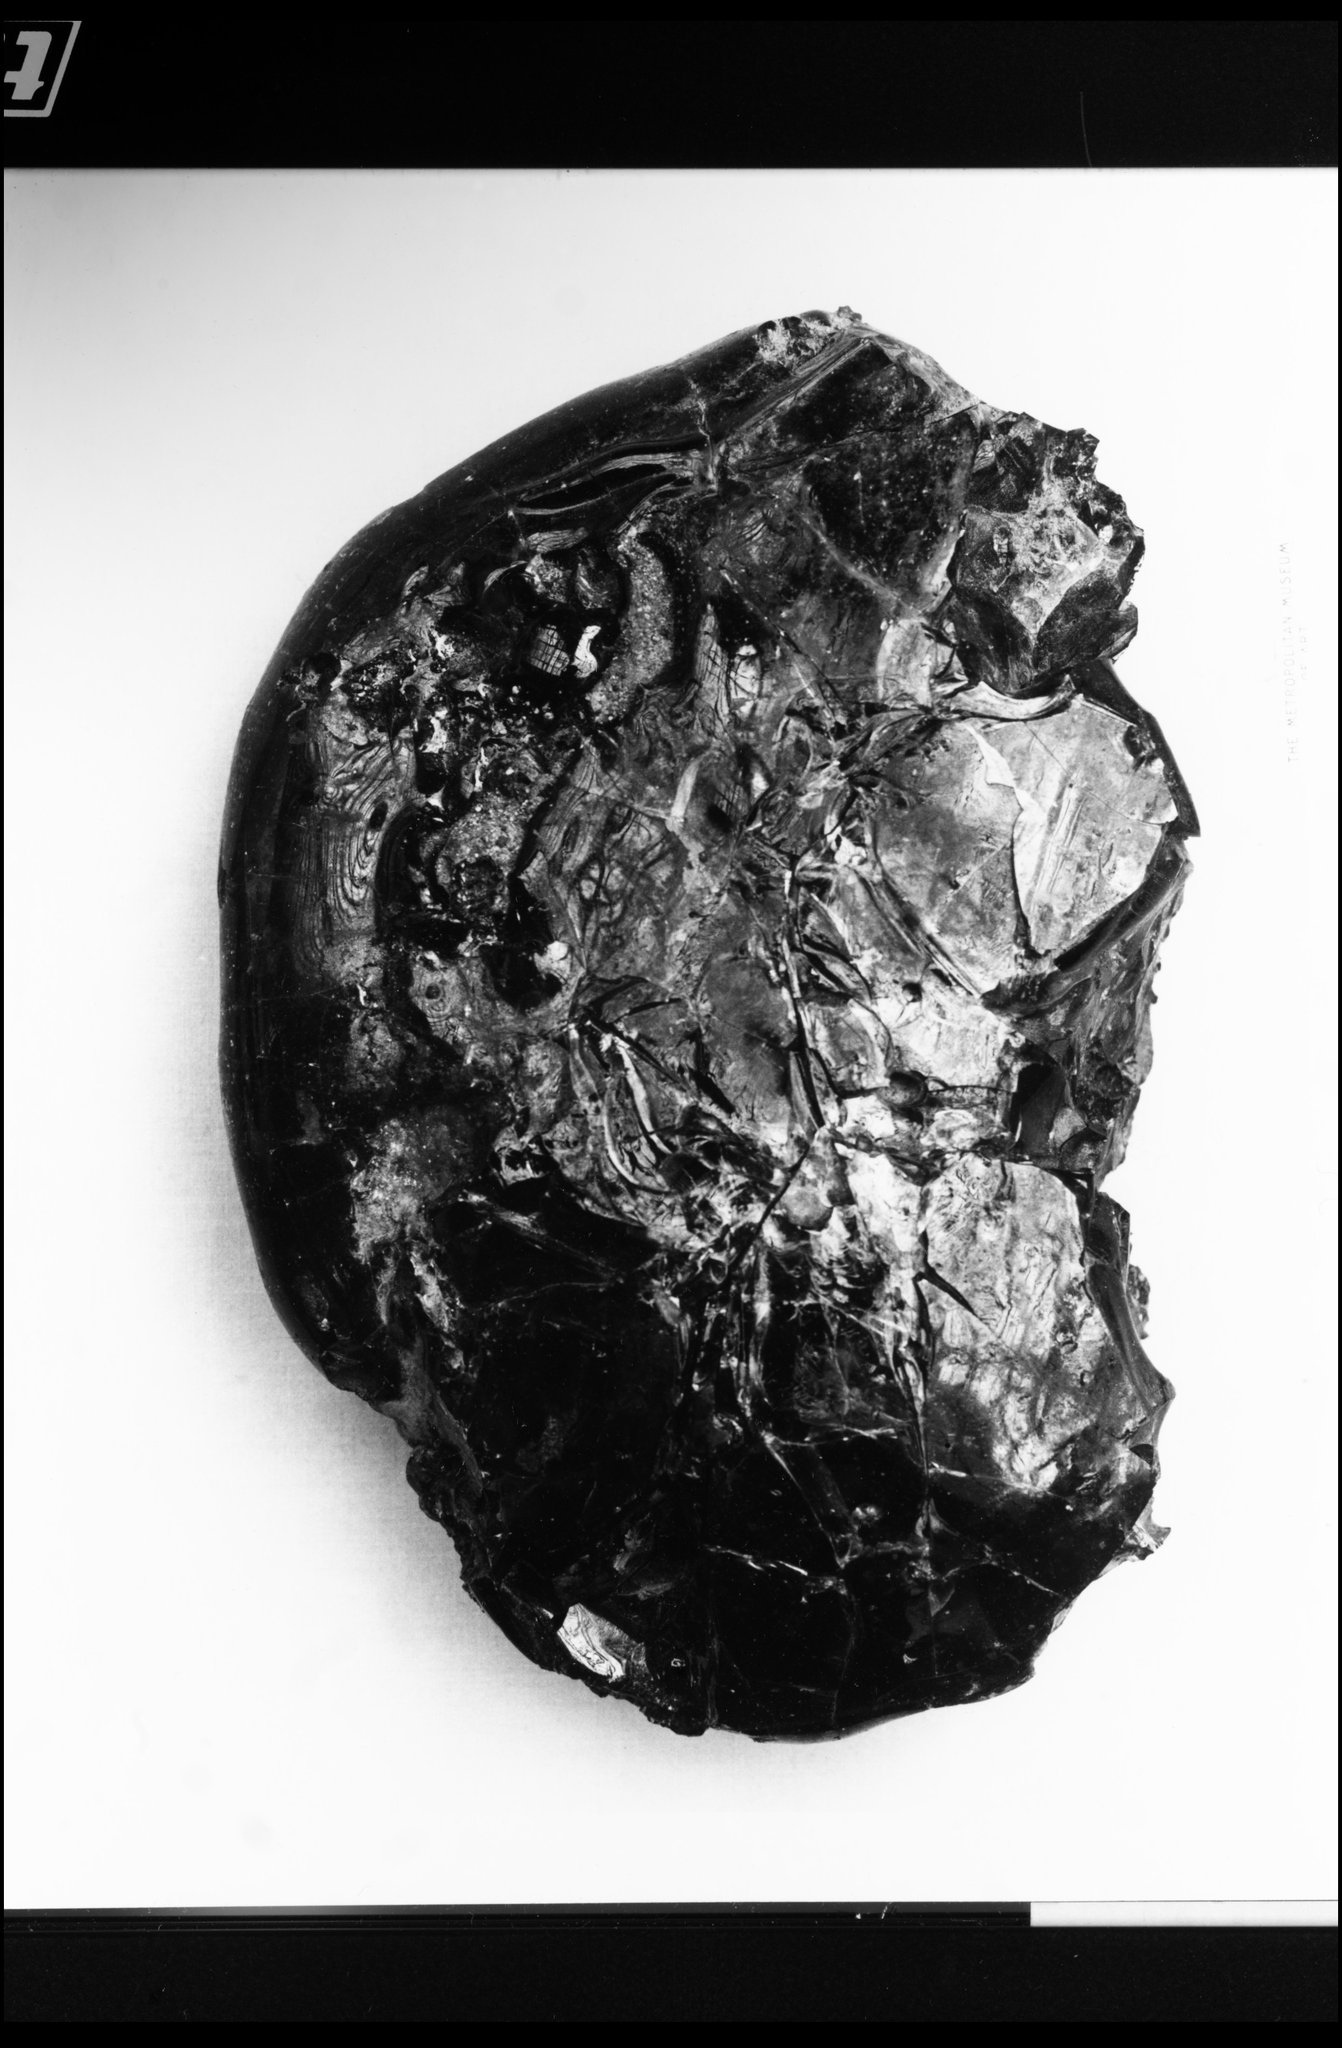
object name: fragment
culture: american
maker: stiegel's manheim factory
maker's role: maker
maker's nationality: american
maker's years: 1763-1774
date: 1763-1774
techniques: glassblowing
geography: united states